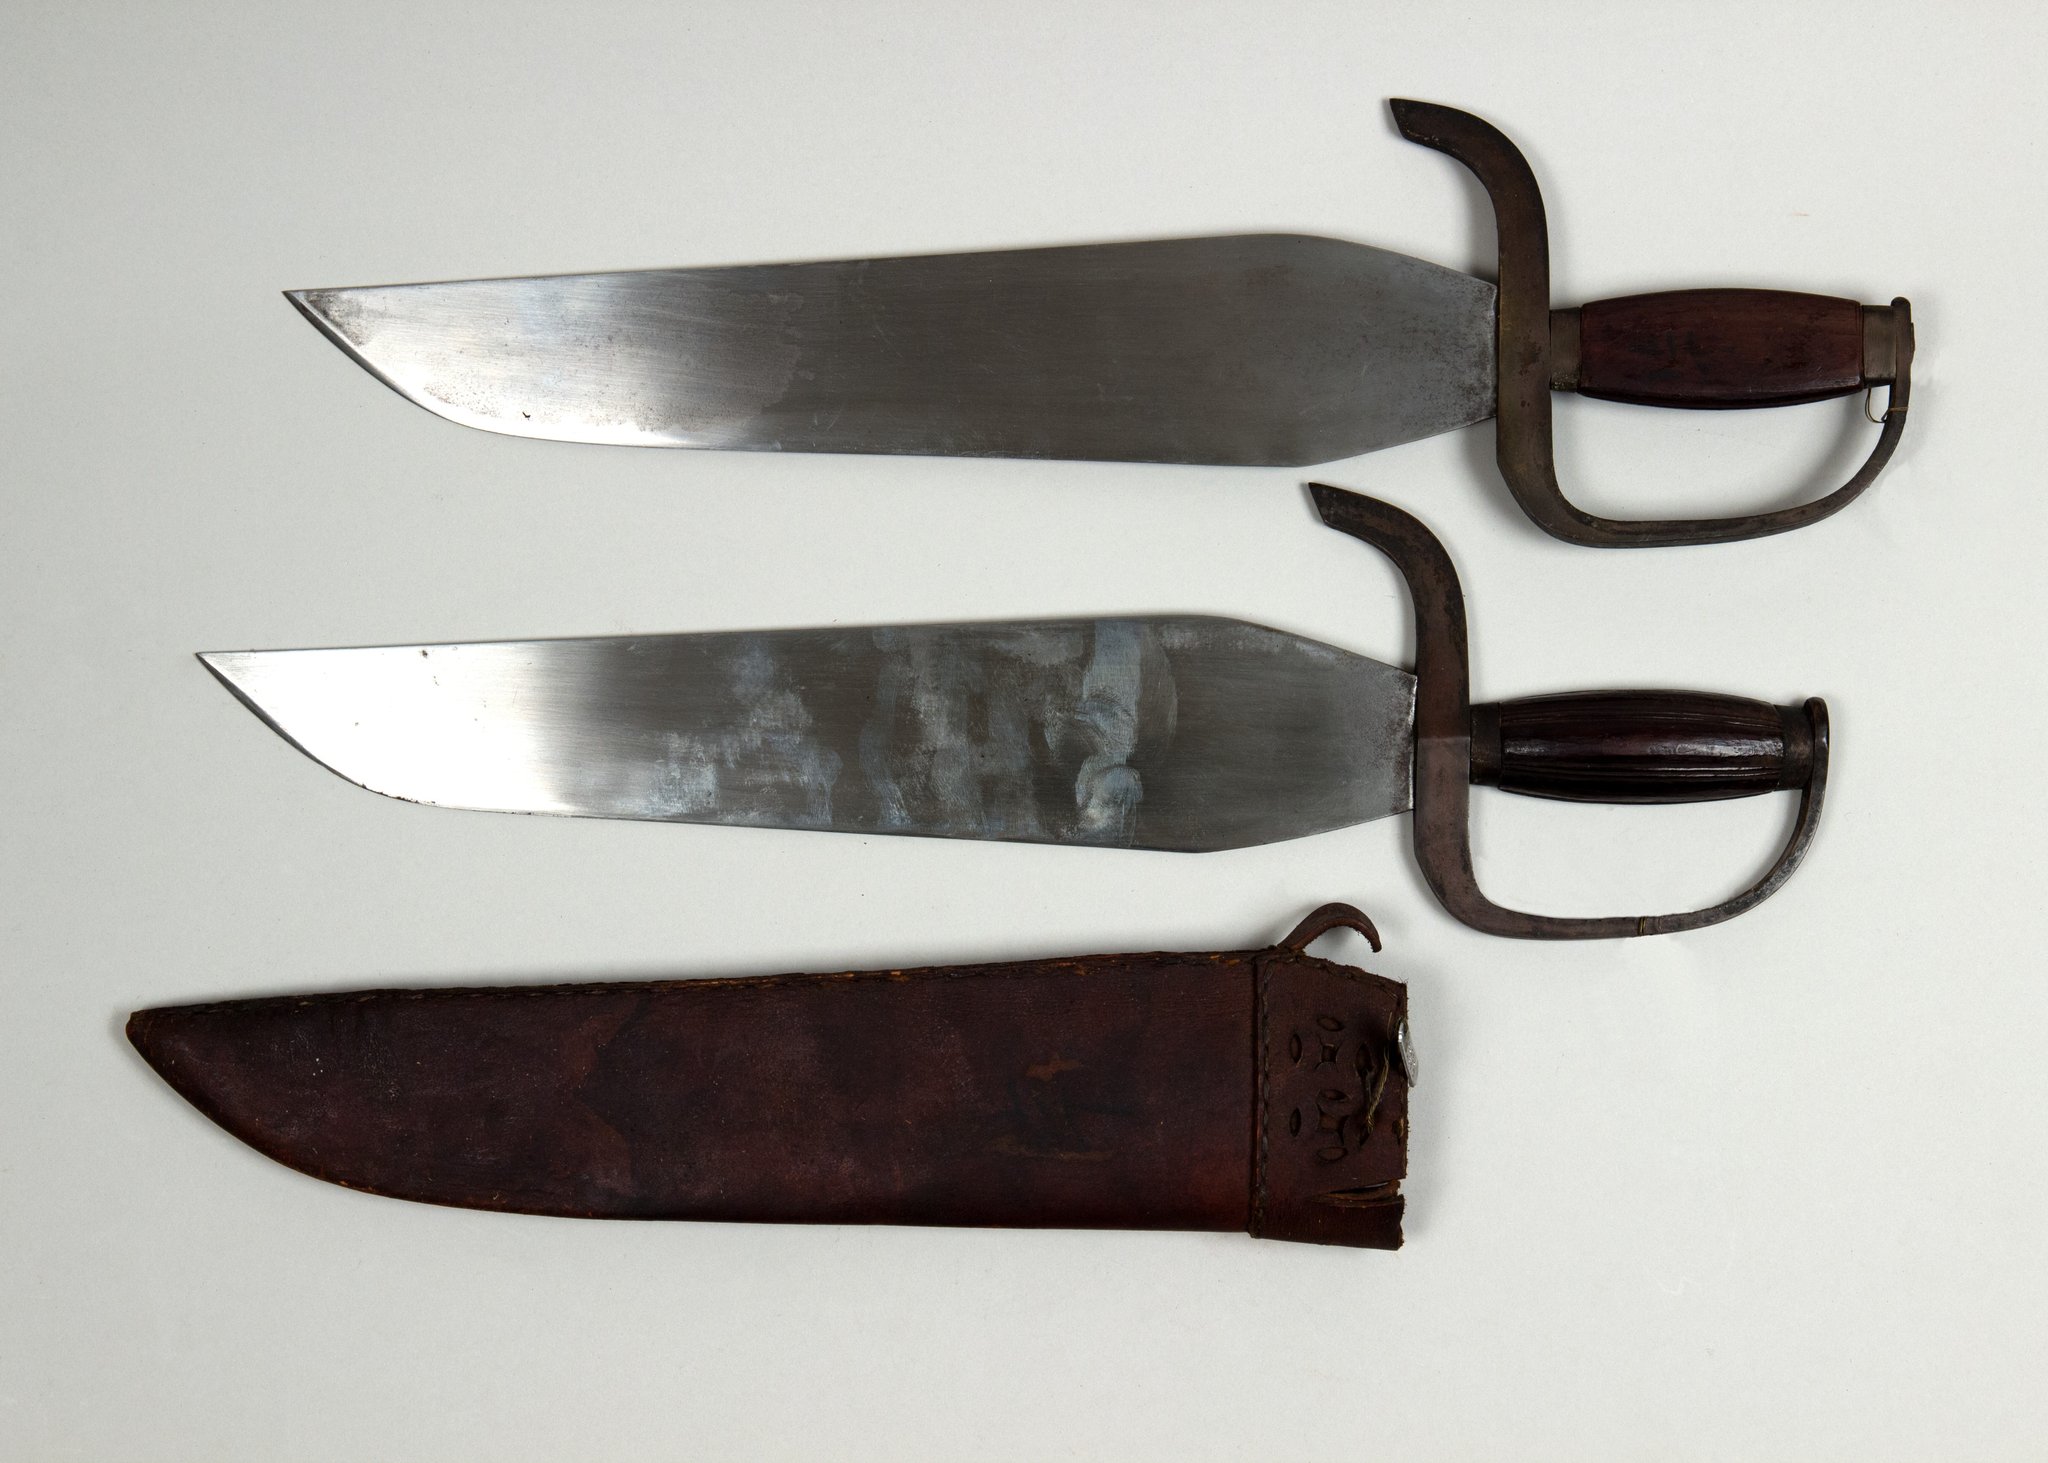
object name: sword with scabbard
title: Double Sword with Scabbard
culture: chinese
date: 1801-1900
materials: brass, leather, steel, wood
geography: china